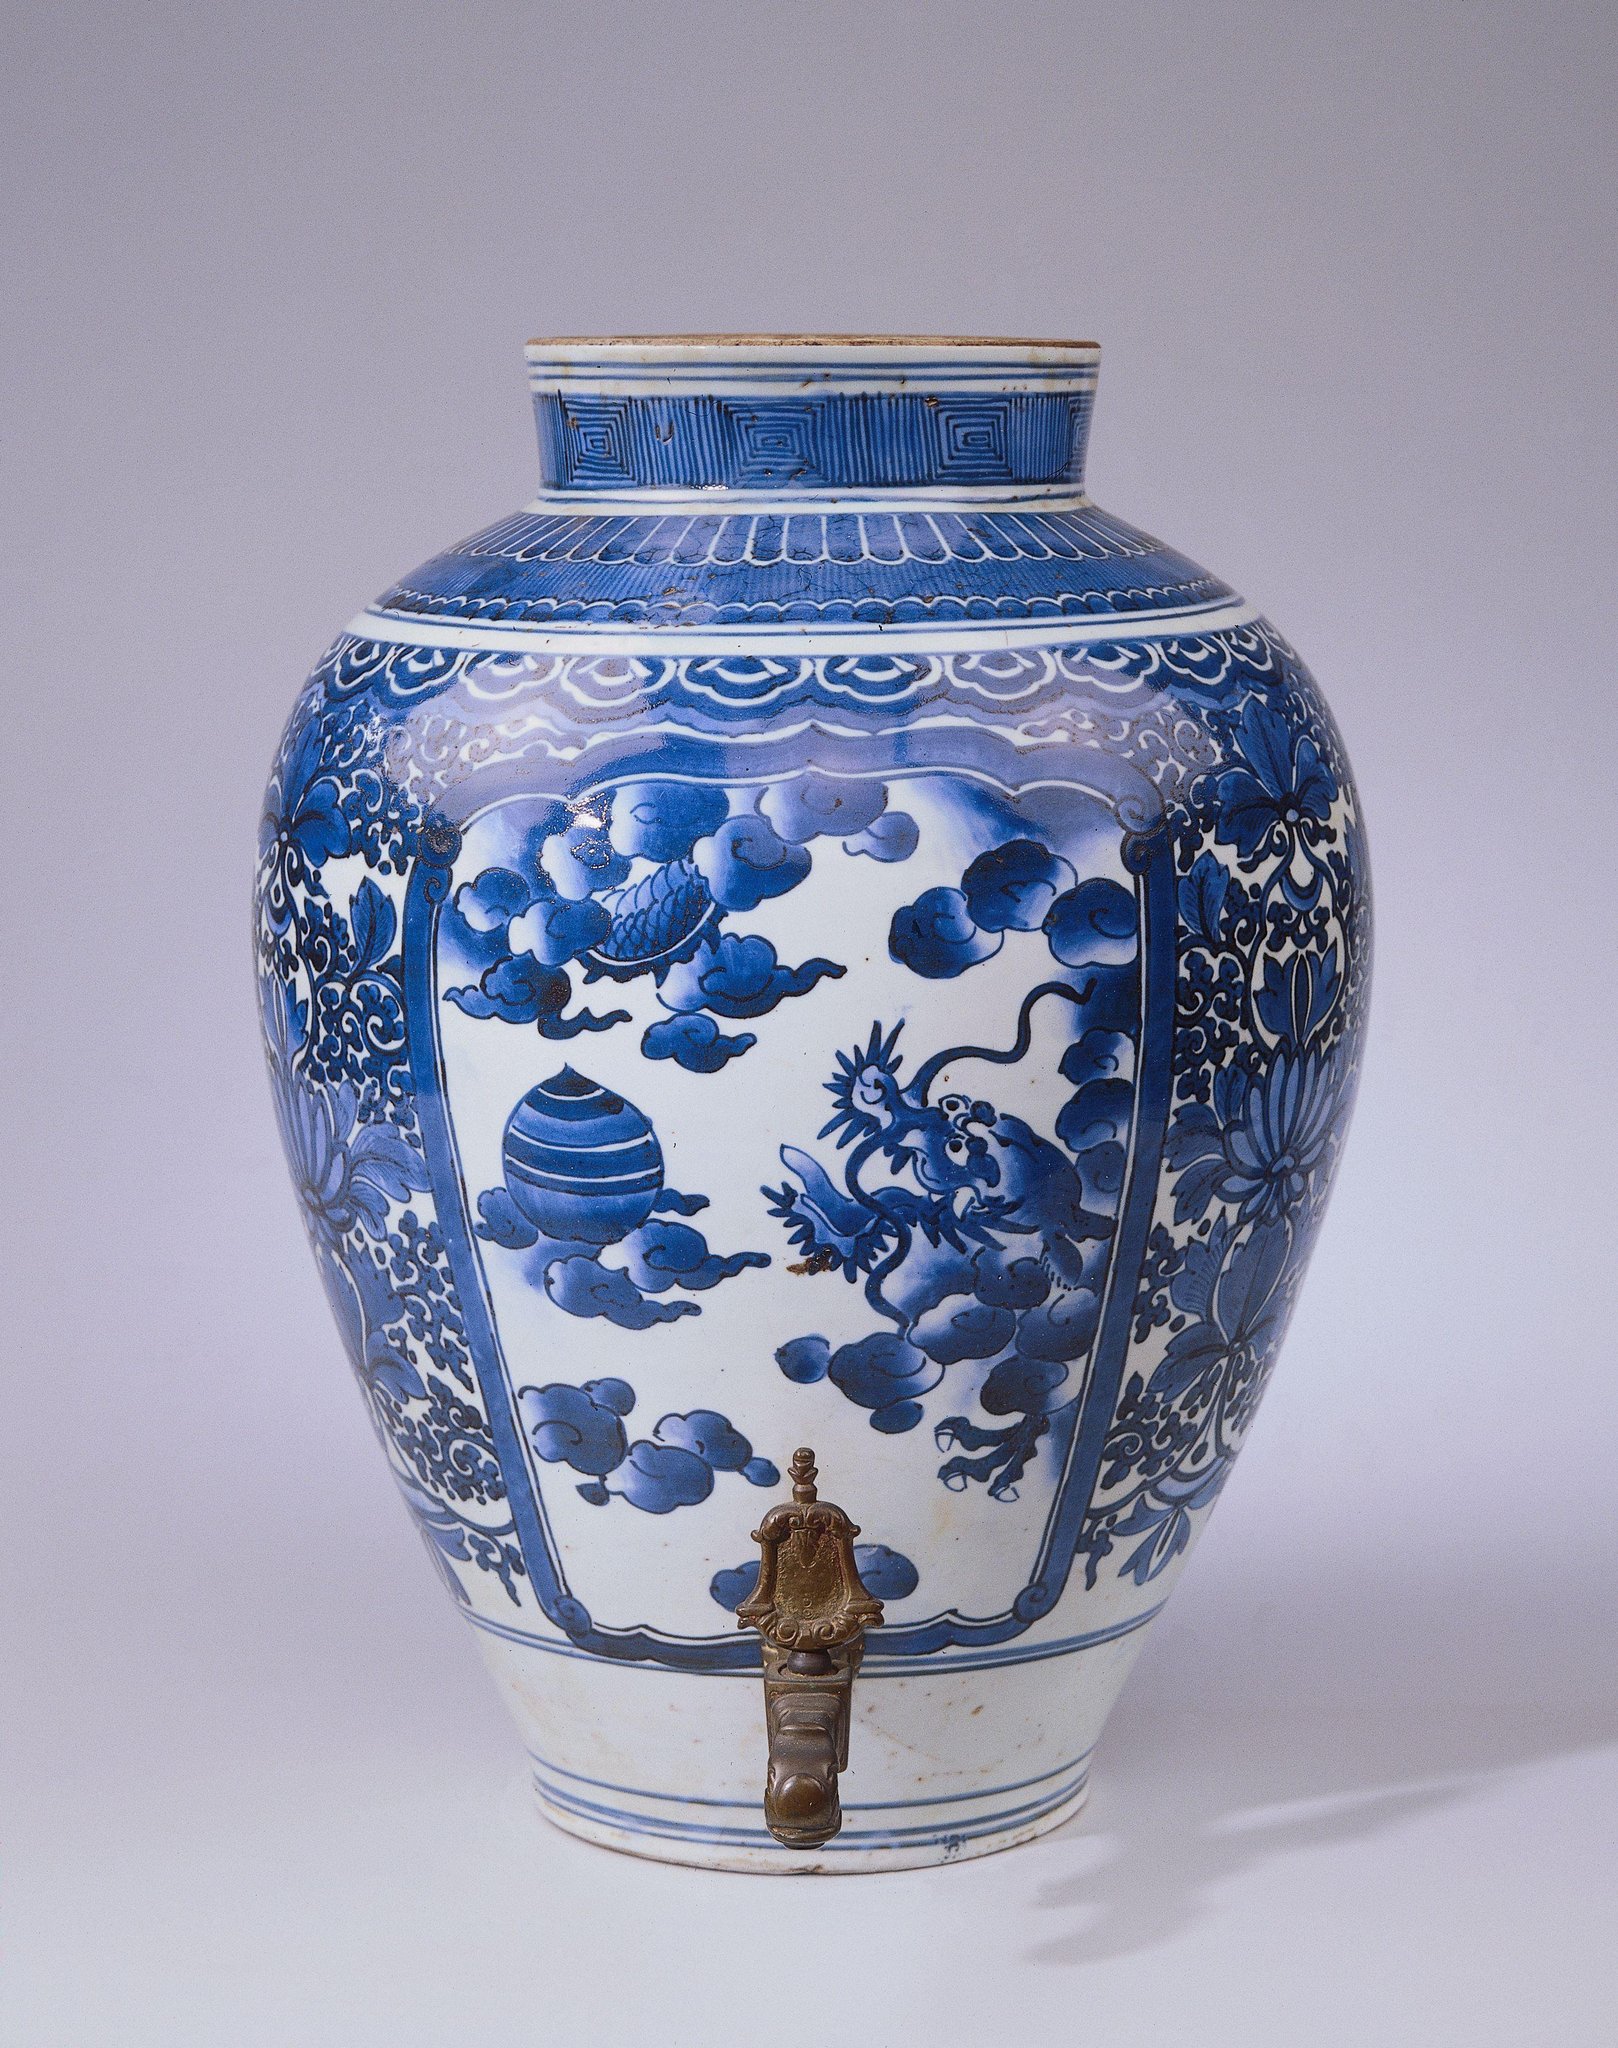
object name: lid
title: Deksel van eivormige pot (fonteinpot) met rots en planten en bloemen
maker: Anonymous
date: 1675-1700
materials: cobalt, glaze, paint, porcelain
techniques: firing, turning, vitrification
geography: arita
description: Deksel, onderglazuur blauw, met doorlopend landschap.